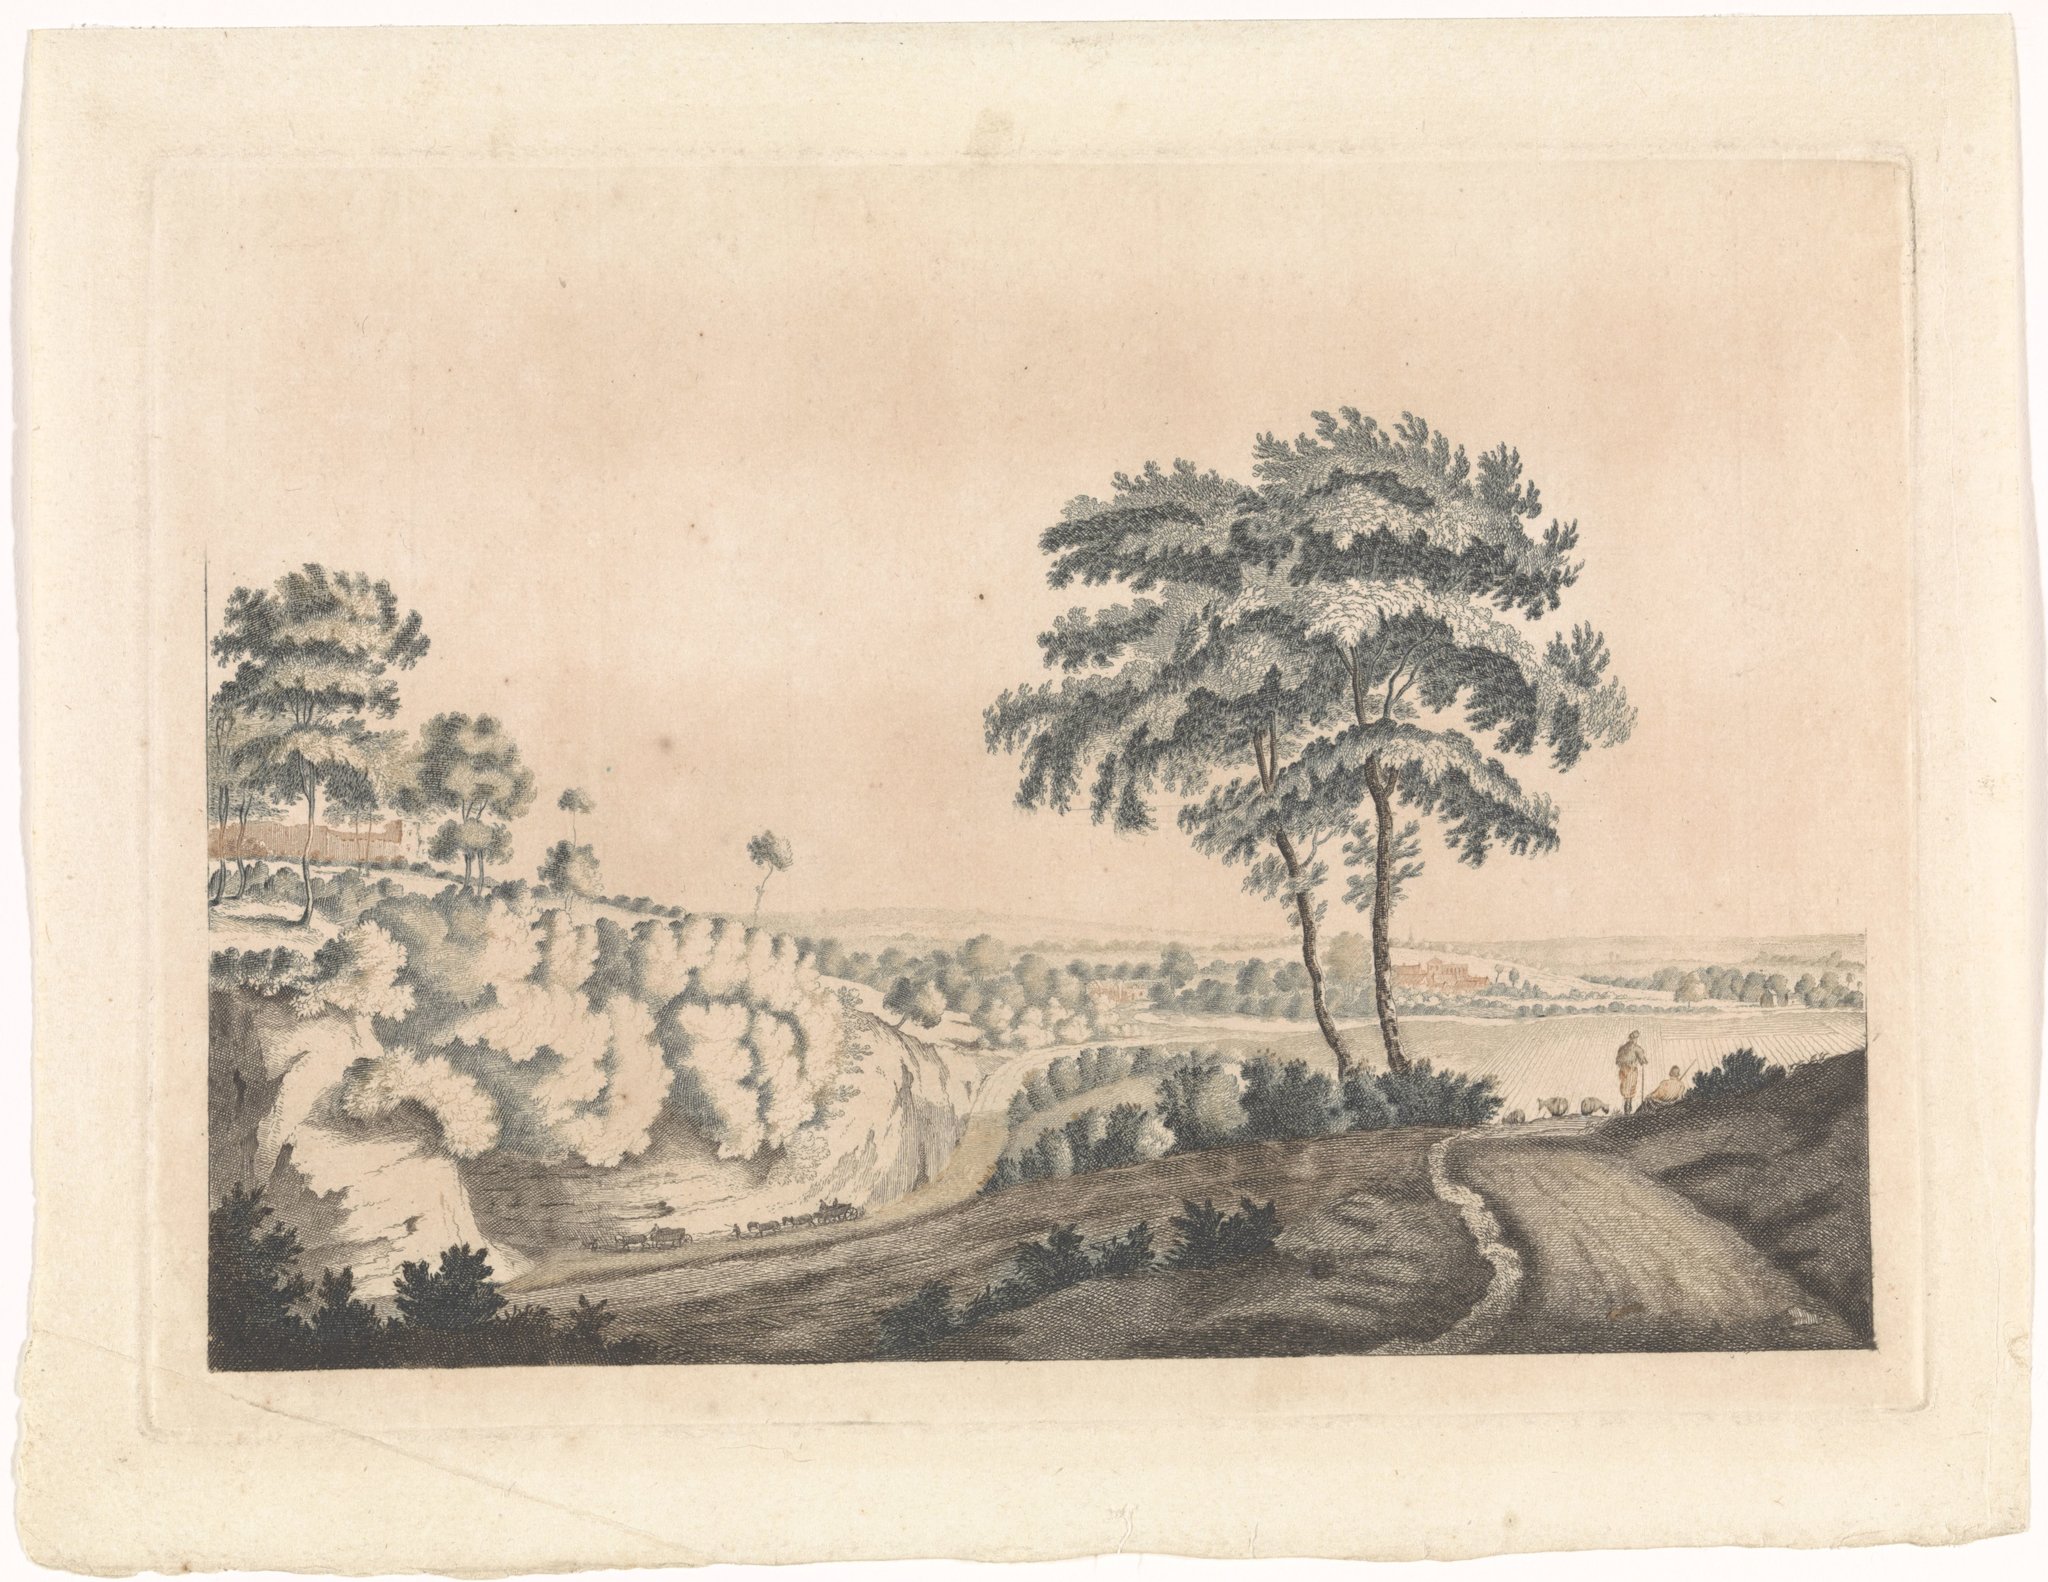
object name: print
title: Landschap met een burcht op een heuvel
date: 1688-1698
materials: paper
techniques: engraving, etching, lithography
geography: netherlands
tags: dale, valley (+ landscape with figures, staffage)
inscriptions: collector's mark: Lugt 2228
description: Landschap met zicht over een dal en links een burcht op een heuvel. Op de voorgrond twee hoge bomen en herders met hun schapen.